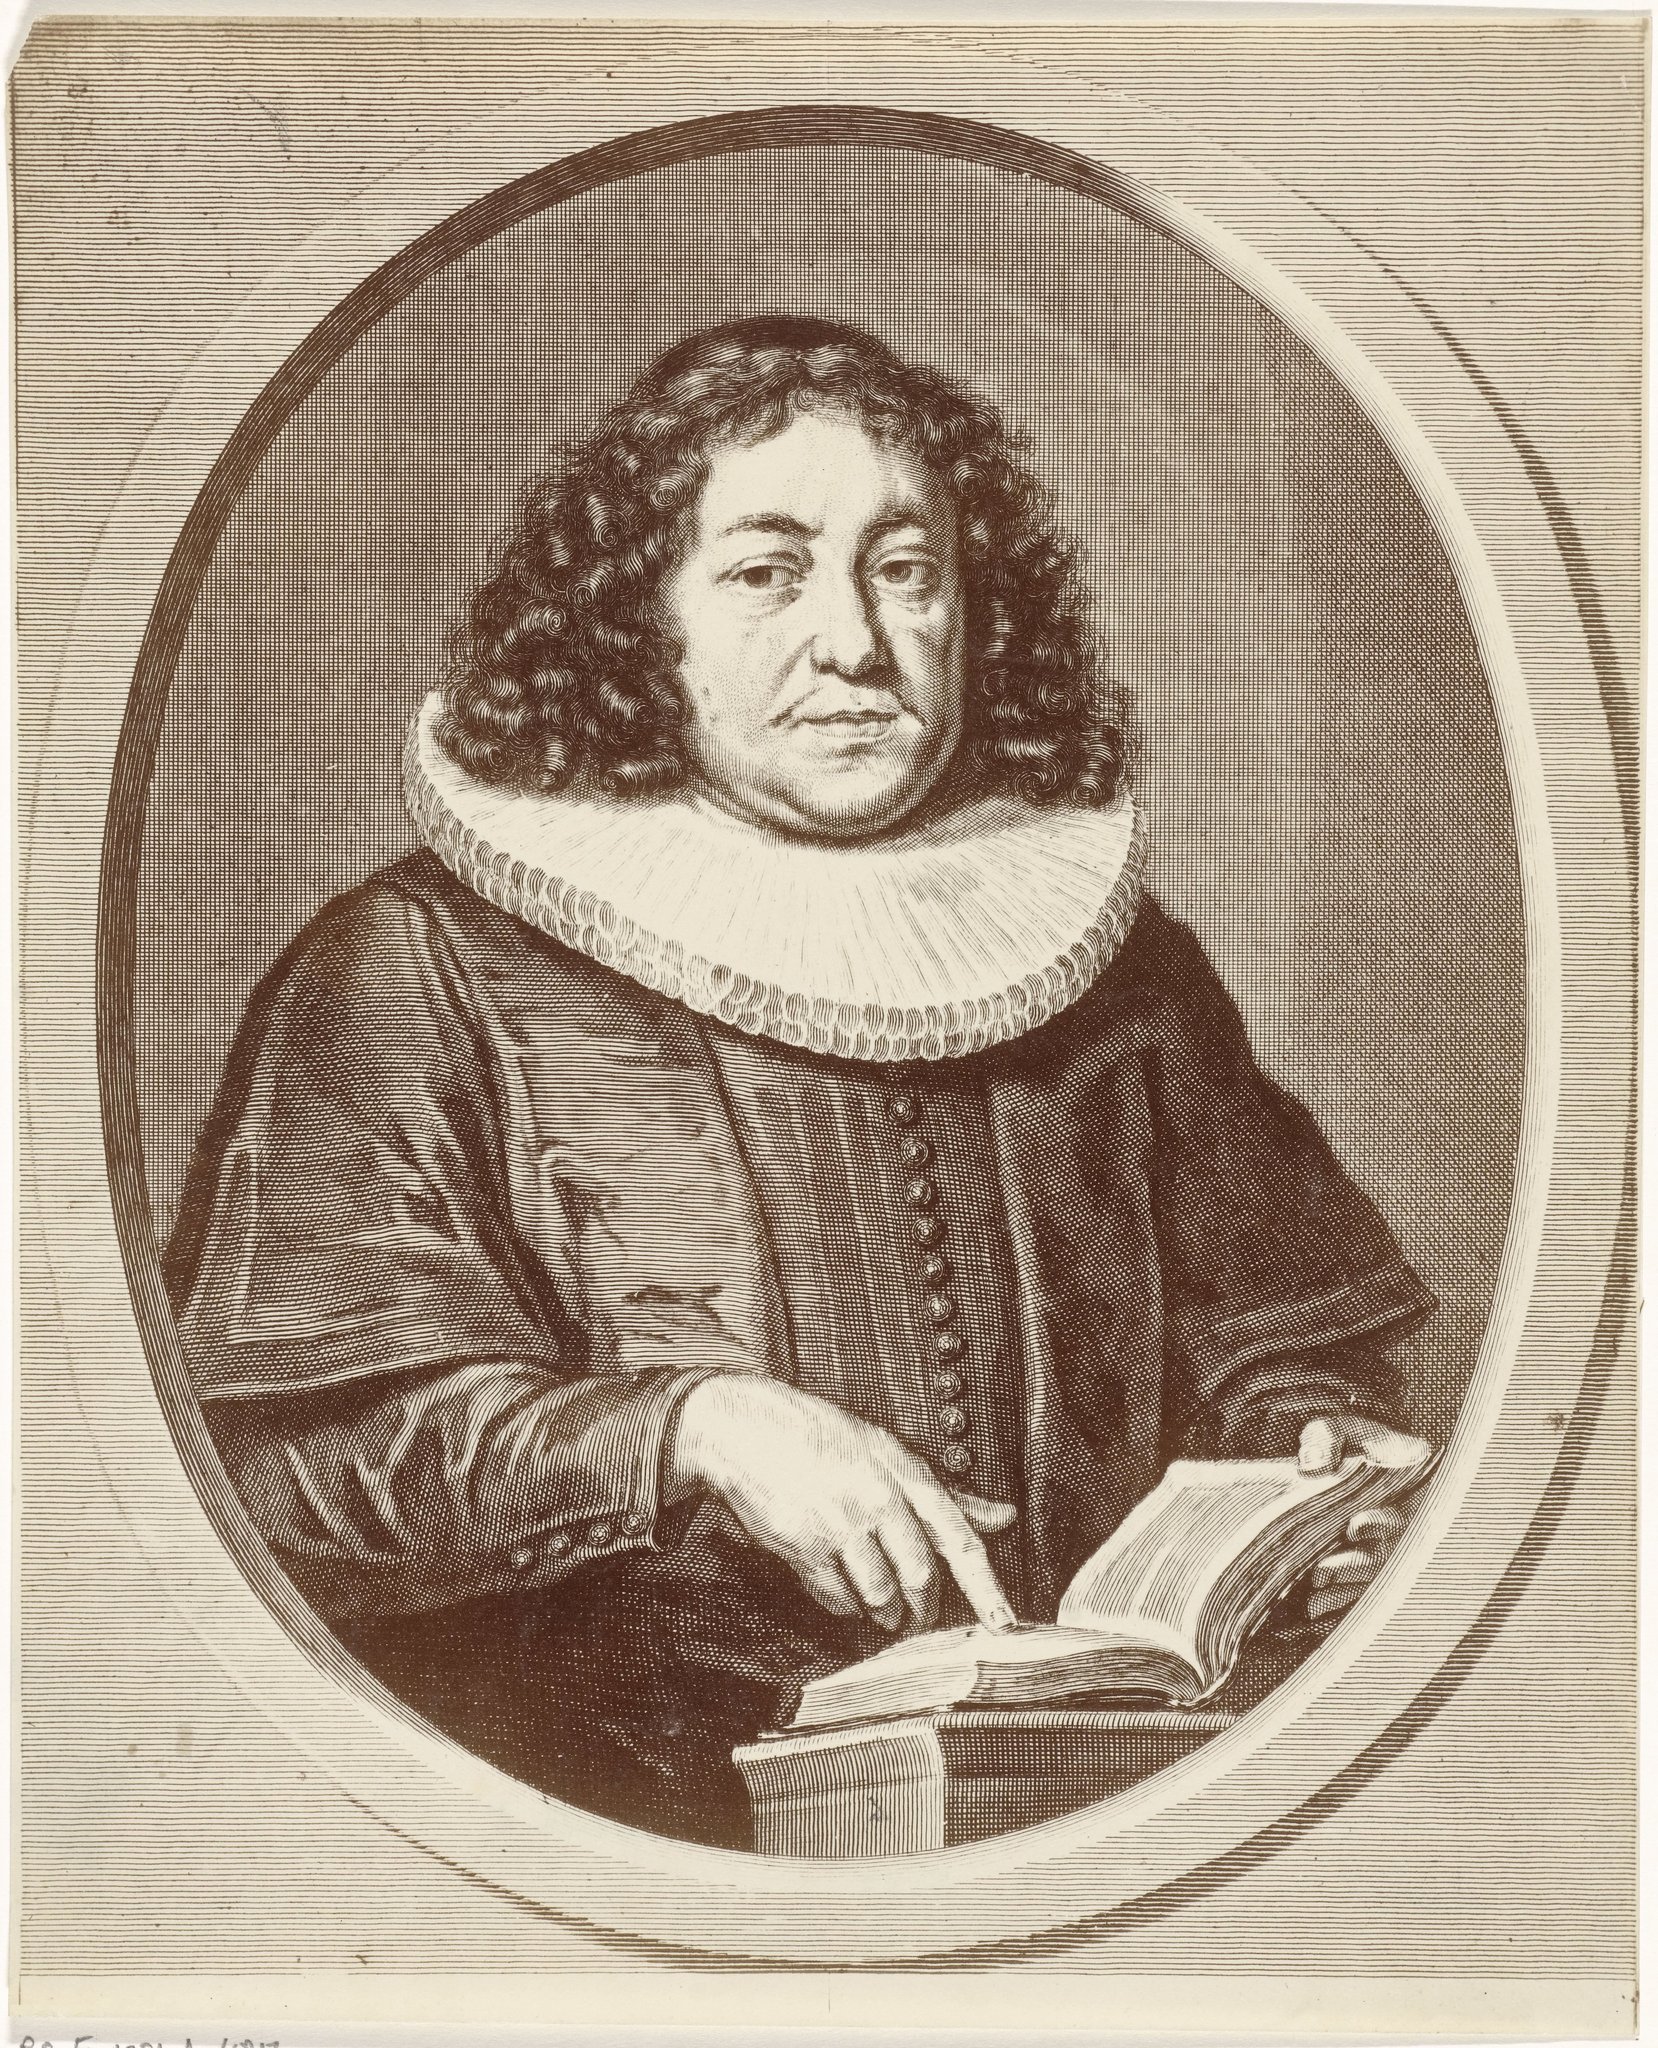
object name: photograph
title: Portret van Johann Winckler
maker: Anonymous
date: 1840-1881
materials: paper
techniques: photography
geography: amsterdam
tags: golzern, hamburg, predikant, oriëntalist, luthers theoloog, johann winckler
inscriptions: collector's mark: Lugt 2228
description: Fotografische reproductie van de eerste staat van een prent met een portret in ovale lijst van Johann Winckler.